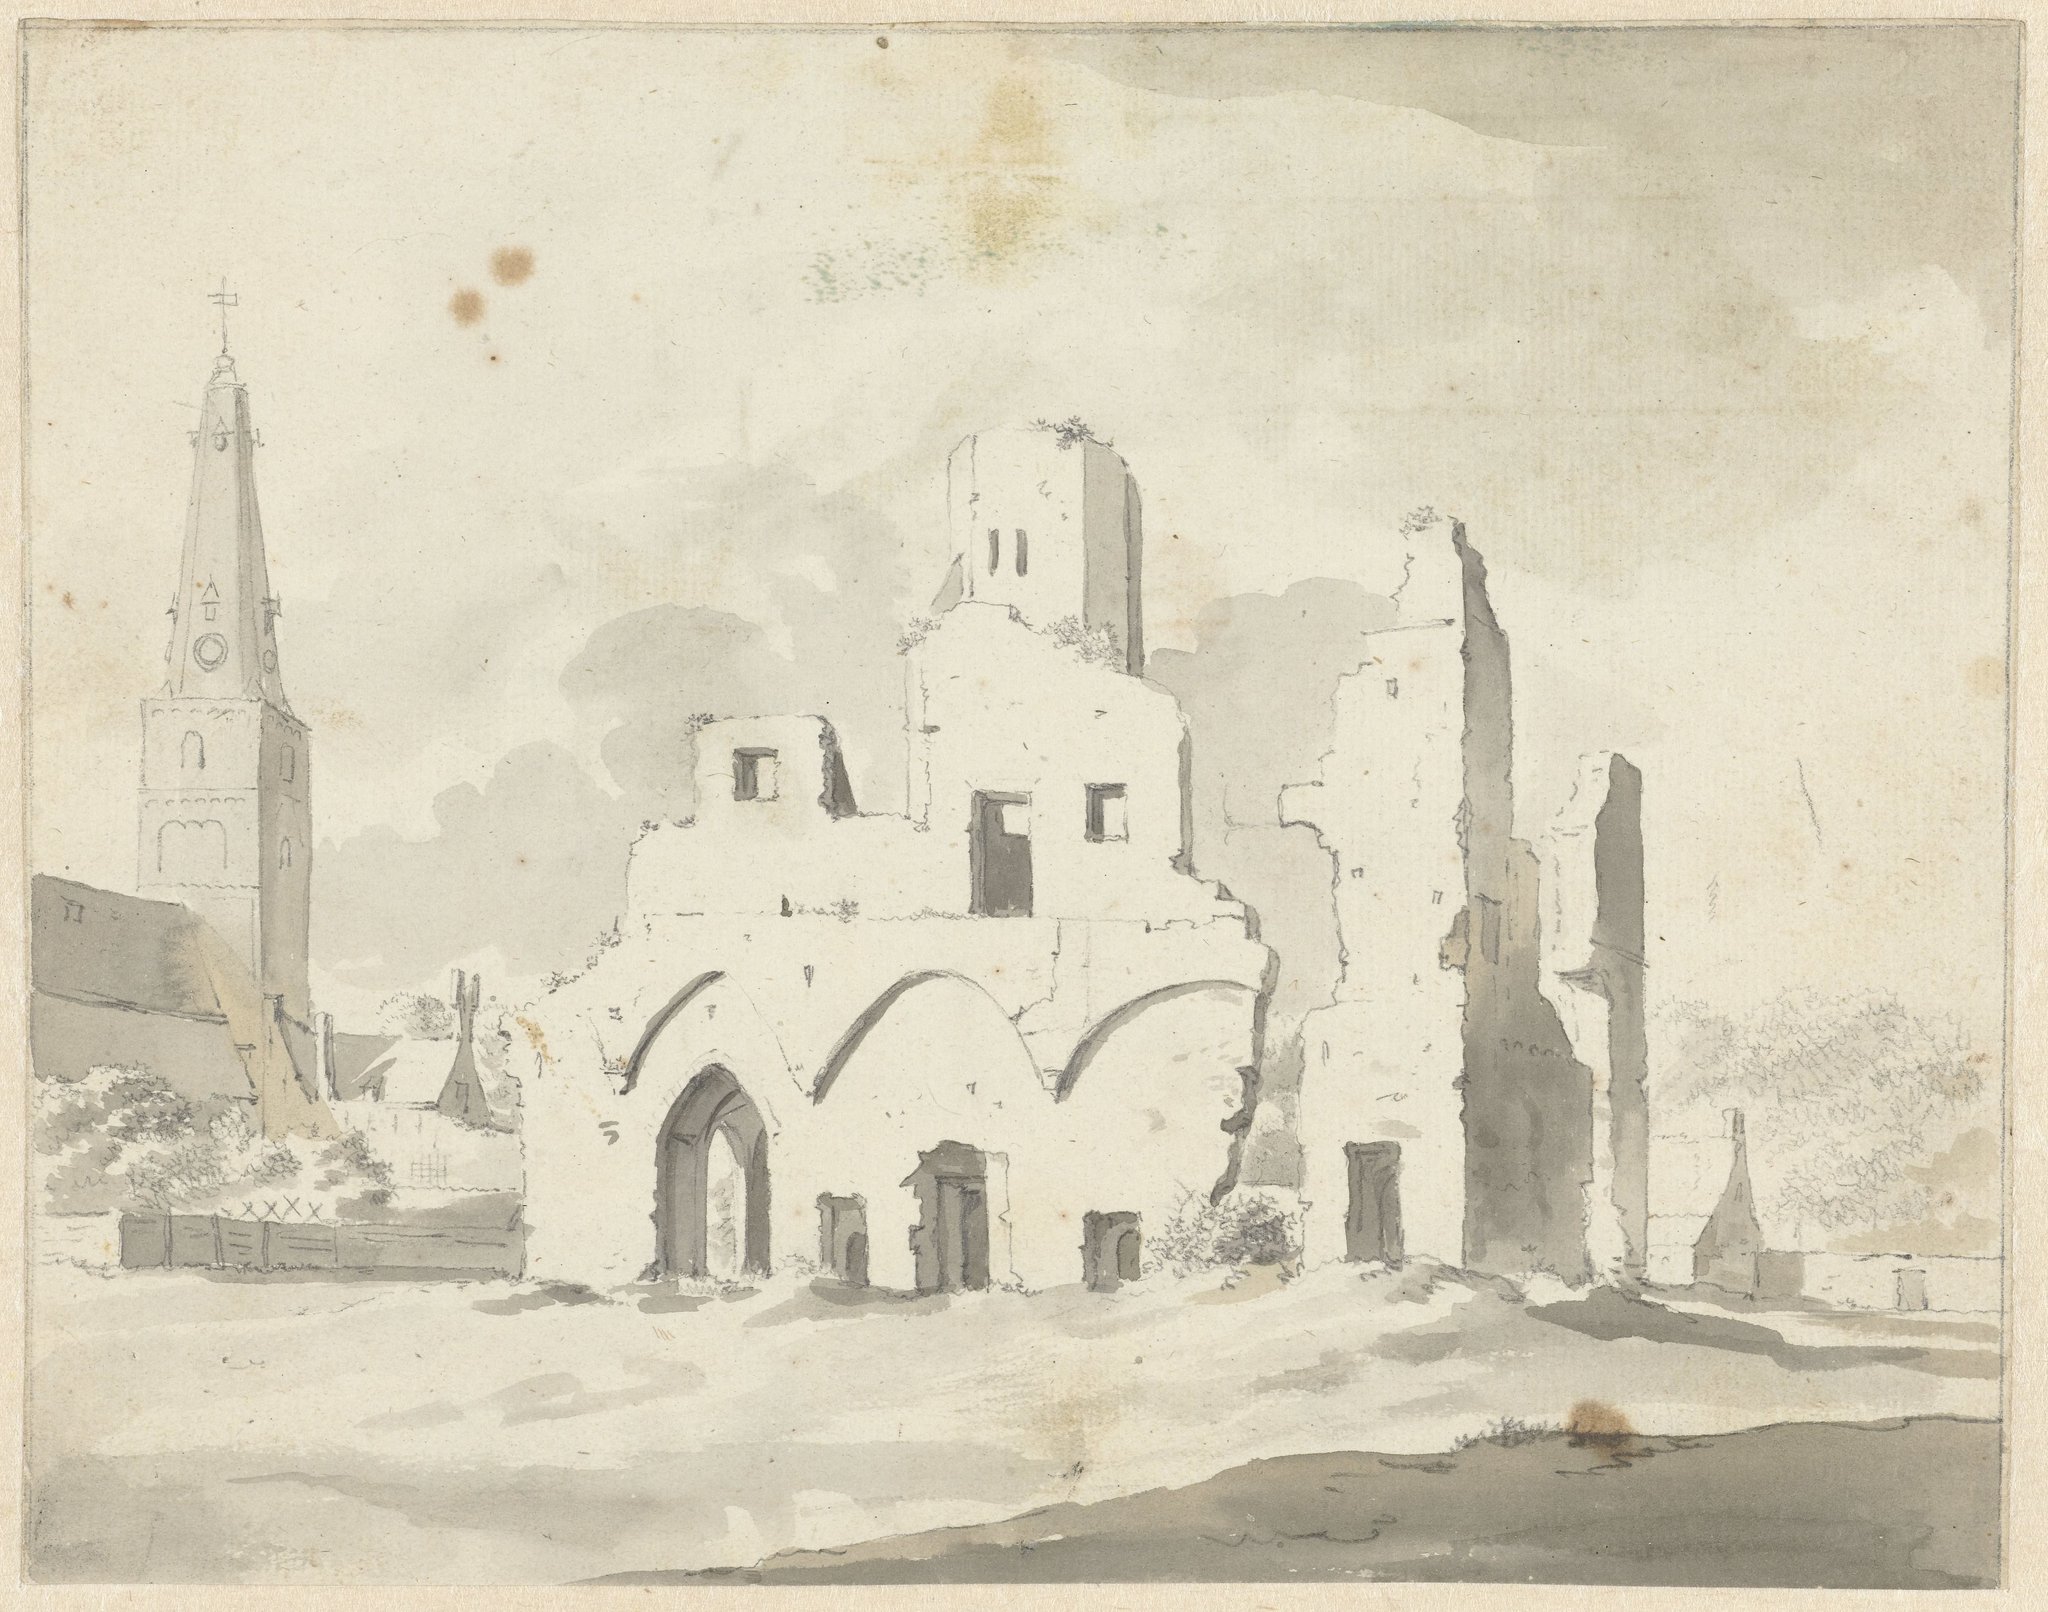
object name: drawing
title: De ruïne van abdij van Rijnsburg met de kerk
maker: johannes huibert prins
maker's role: draughtsman, painter, print maker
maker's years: 1757-1806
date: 1781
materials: paper, pencil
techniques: brush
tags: ruin of a building ~ architecture, abbey, monastery, convent ~ roman catholic church, church (exterior)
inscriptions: date: ‘1781’